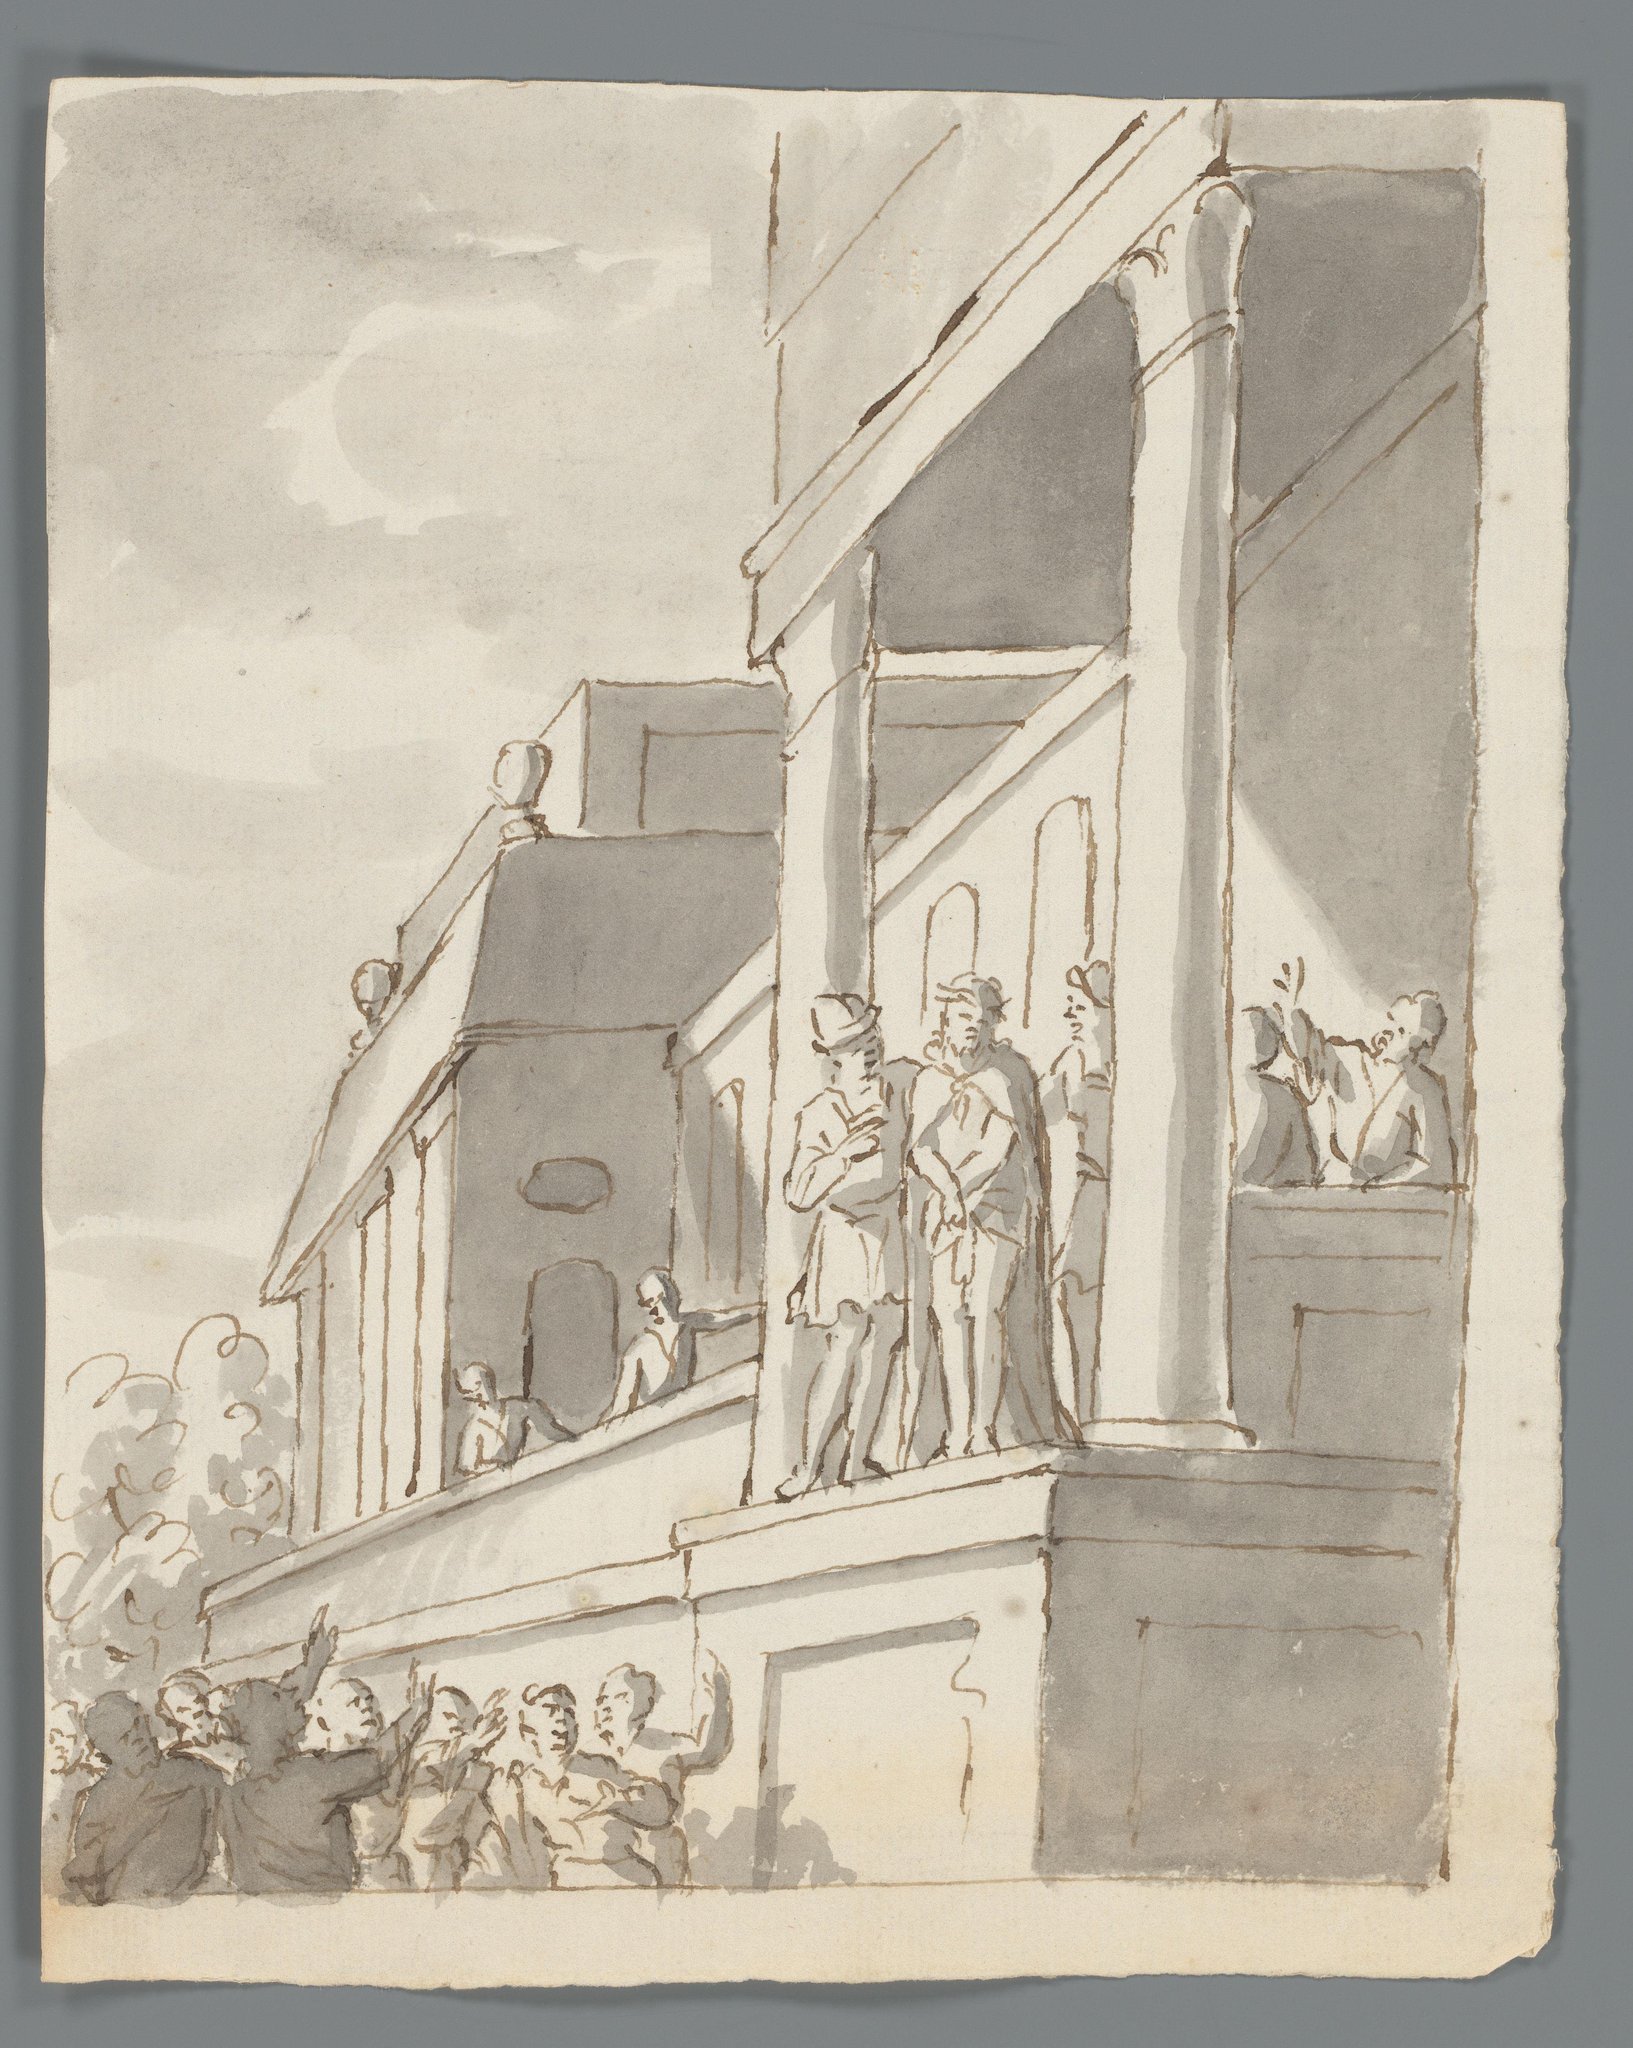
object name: drawing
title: Ecce homo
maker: matthijs balen (1684-1766)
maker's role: draughtsman, painter, print maker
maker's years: 1684-1766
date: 1694-1766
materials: paper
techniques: brush, pen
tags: pilate showing christ to the people, 'ostentatio christi', 'ecce homo' (john 19:4-6)